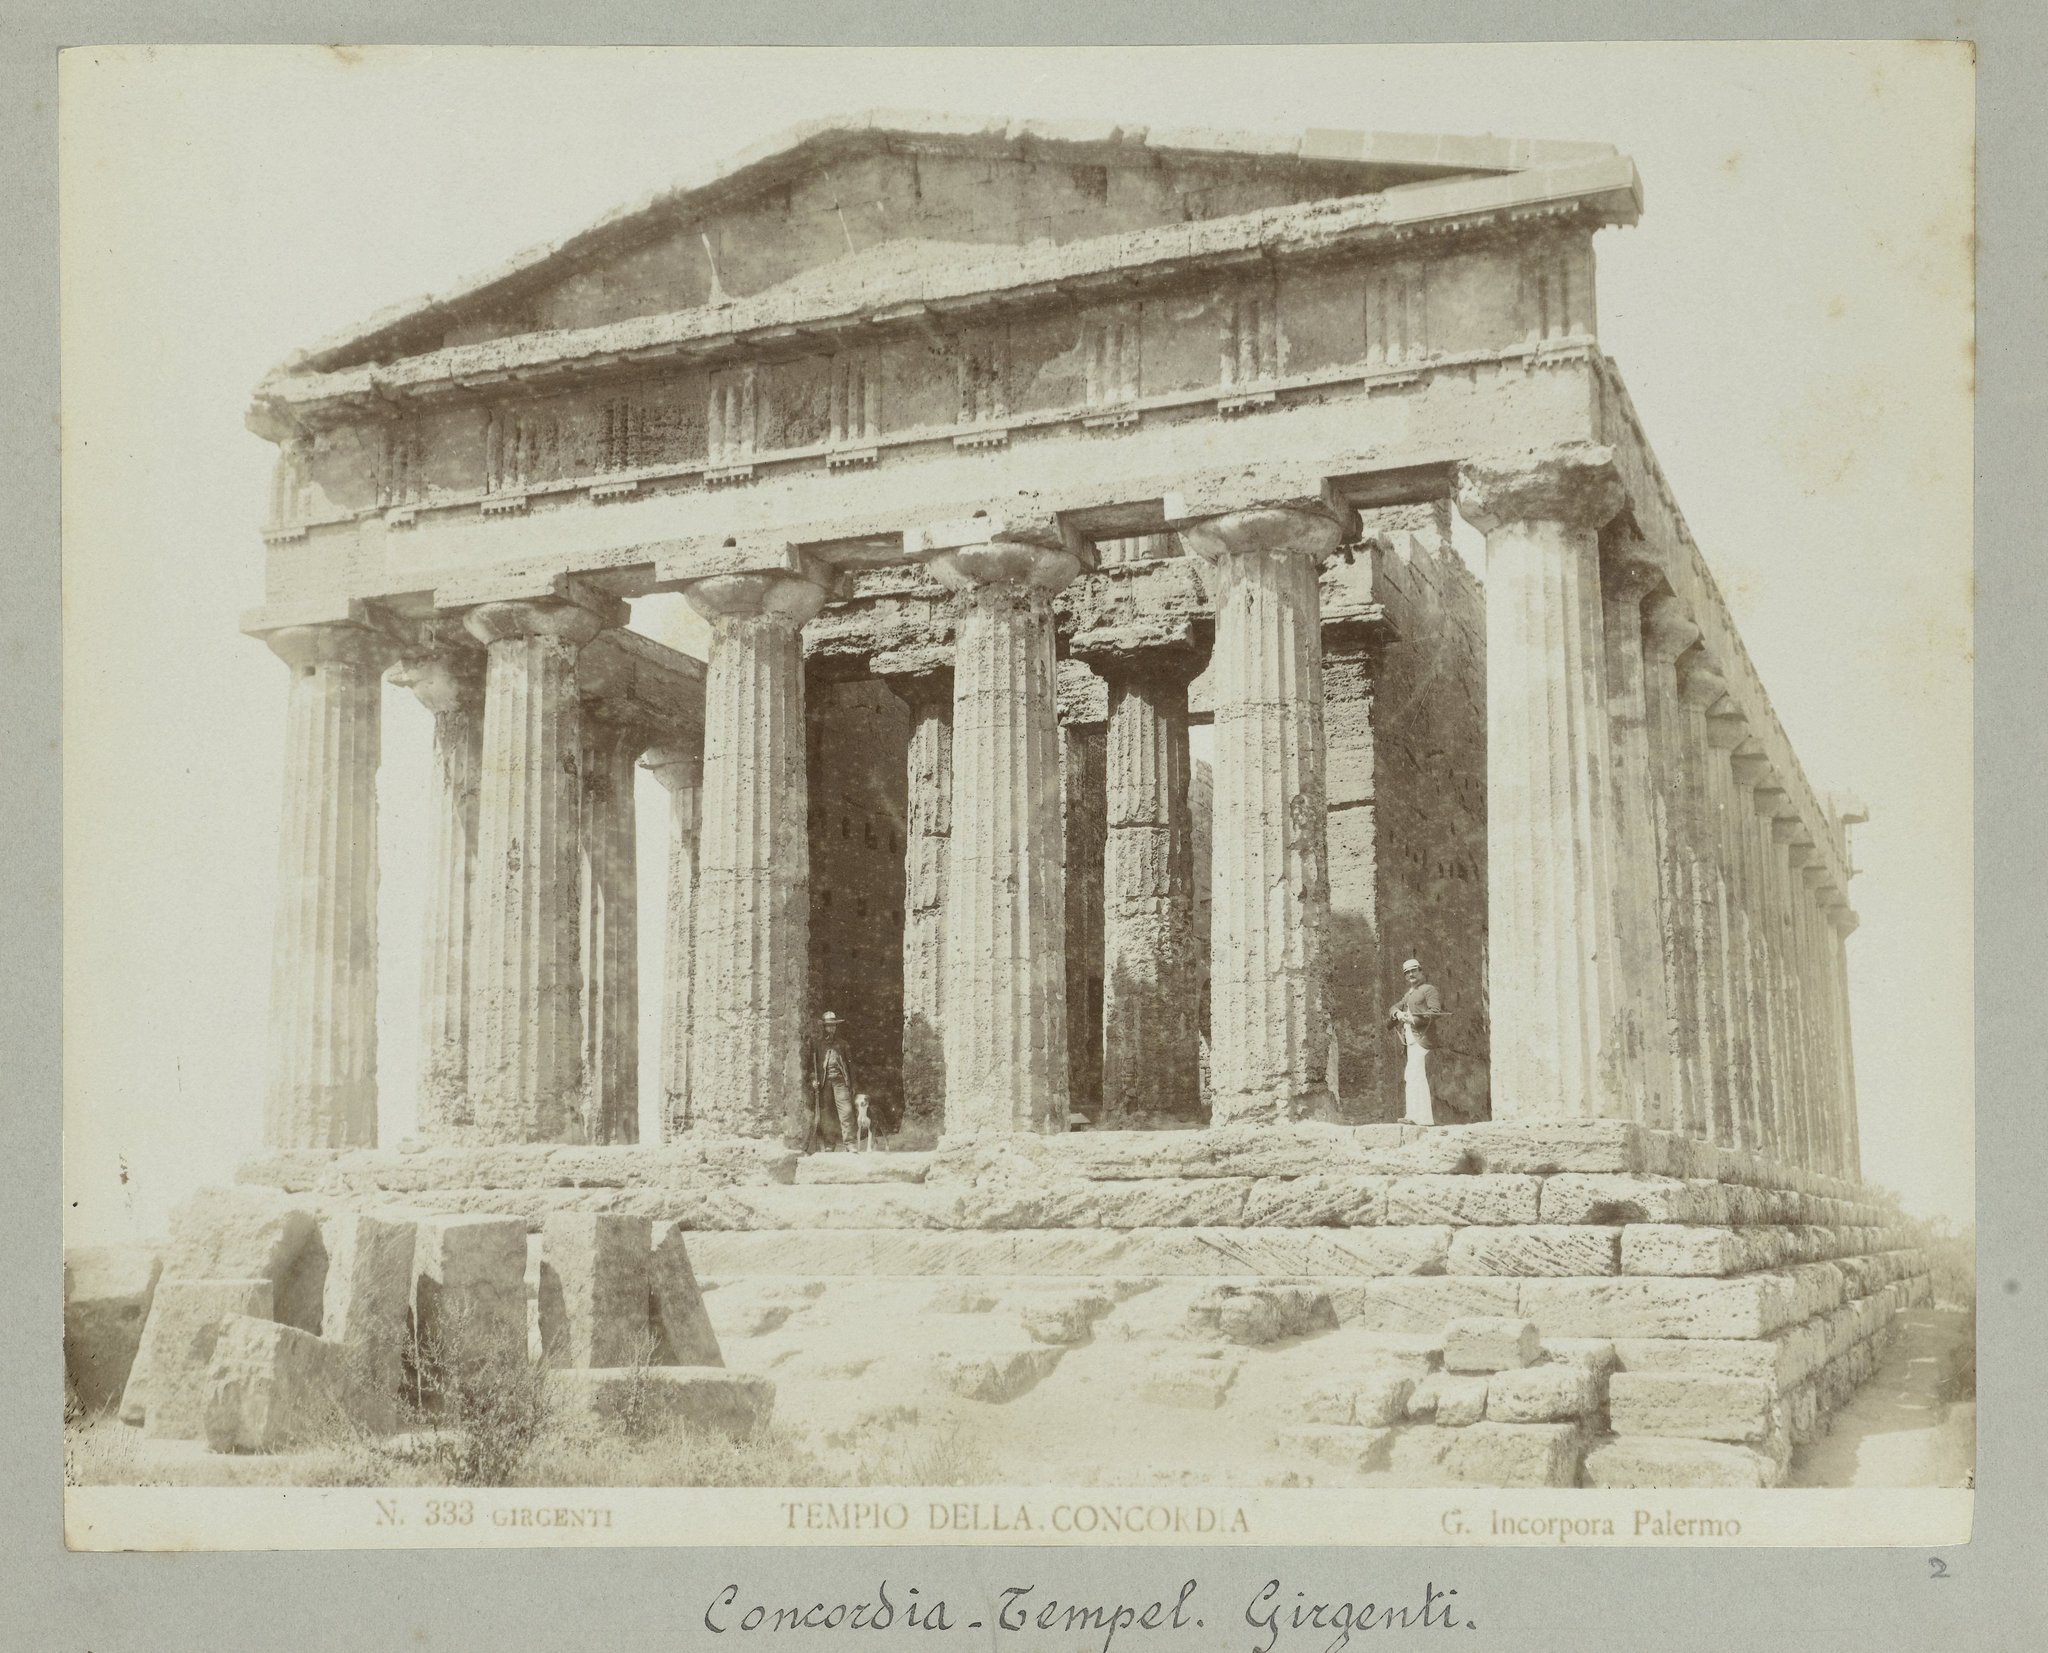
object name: photograph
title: Concordia tempel Girgenti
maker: giuseppe incorpora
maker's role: fotograaf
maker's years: 1834-1914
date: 1893-1903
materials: cardboard, photographic support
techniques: albumen print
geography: netherlands